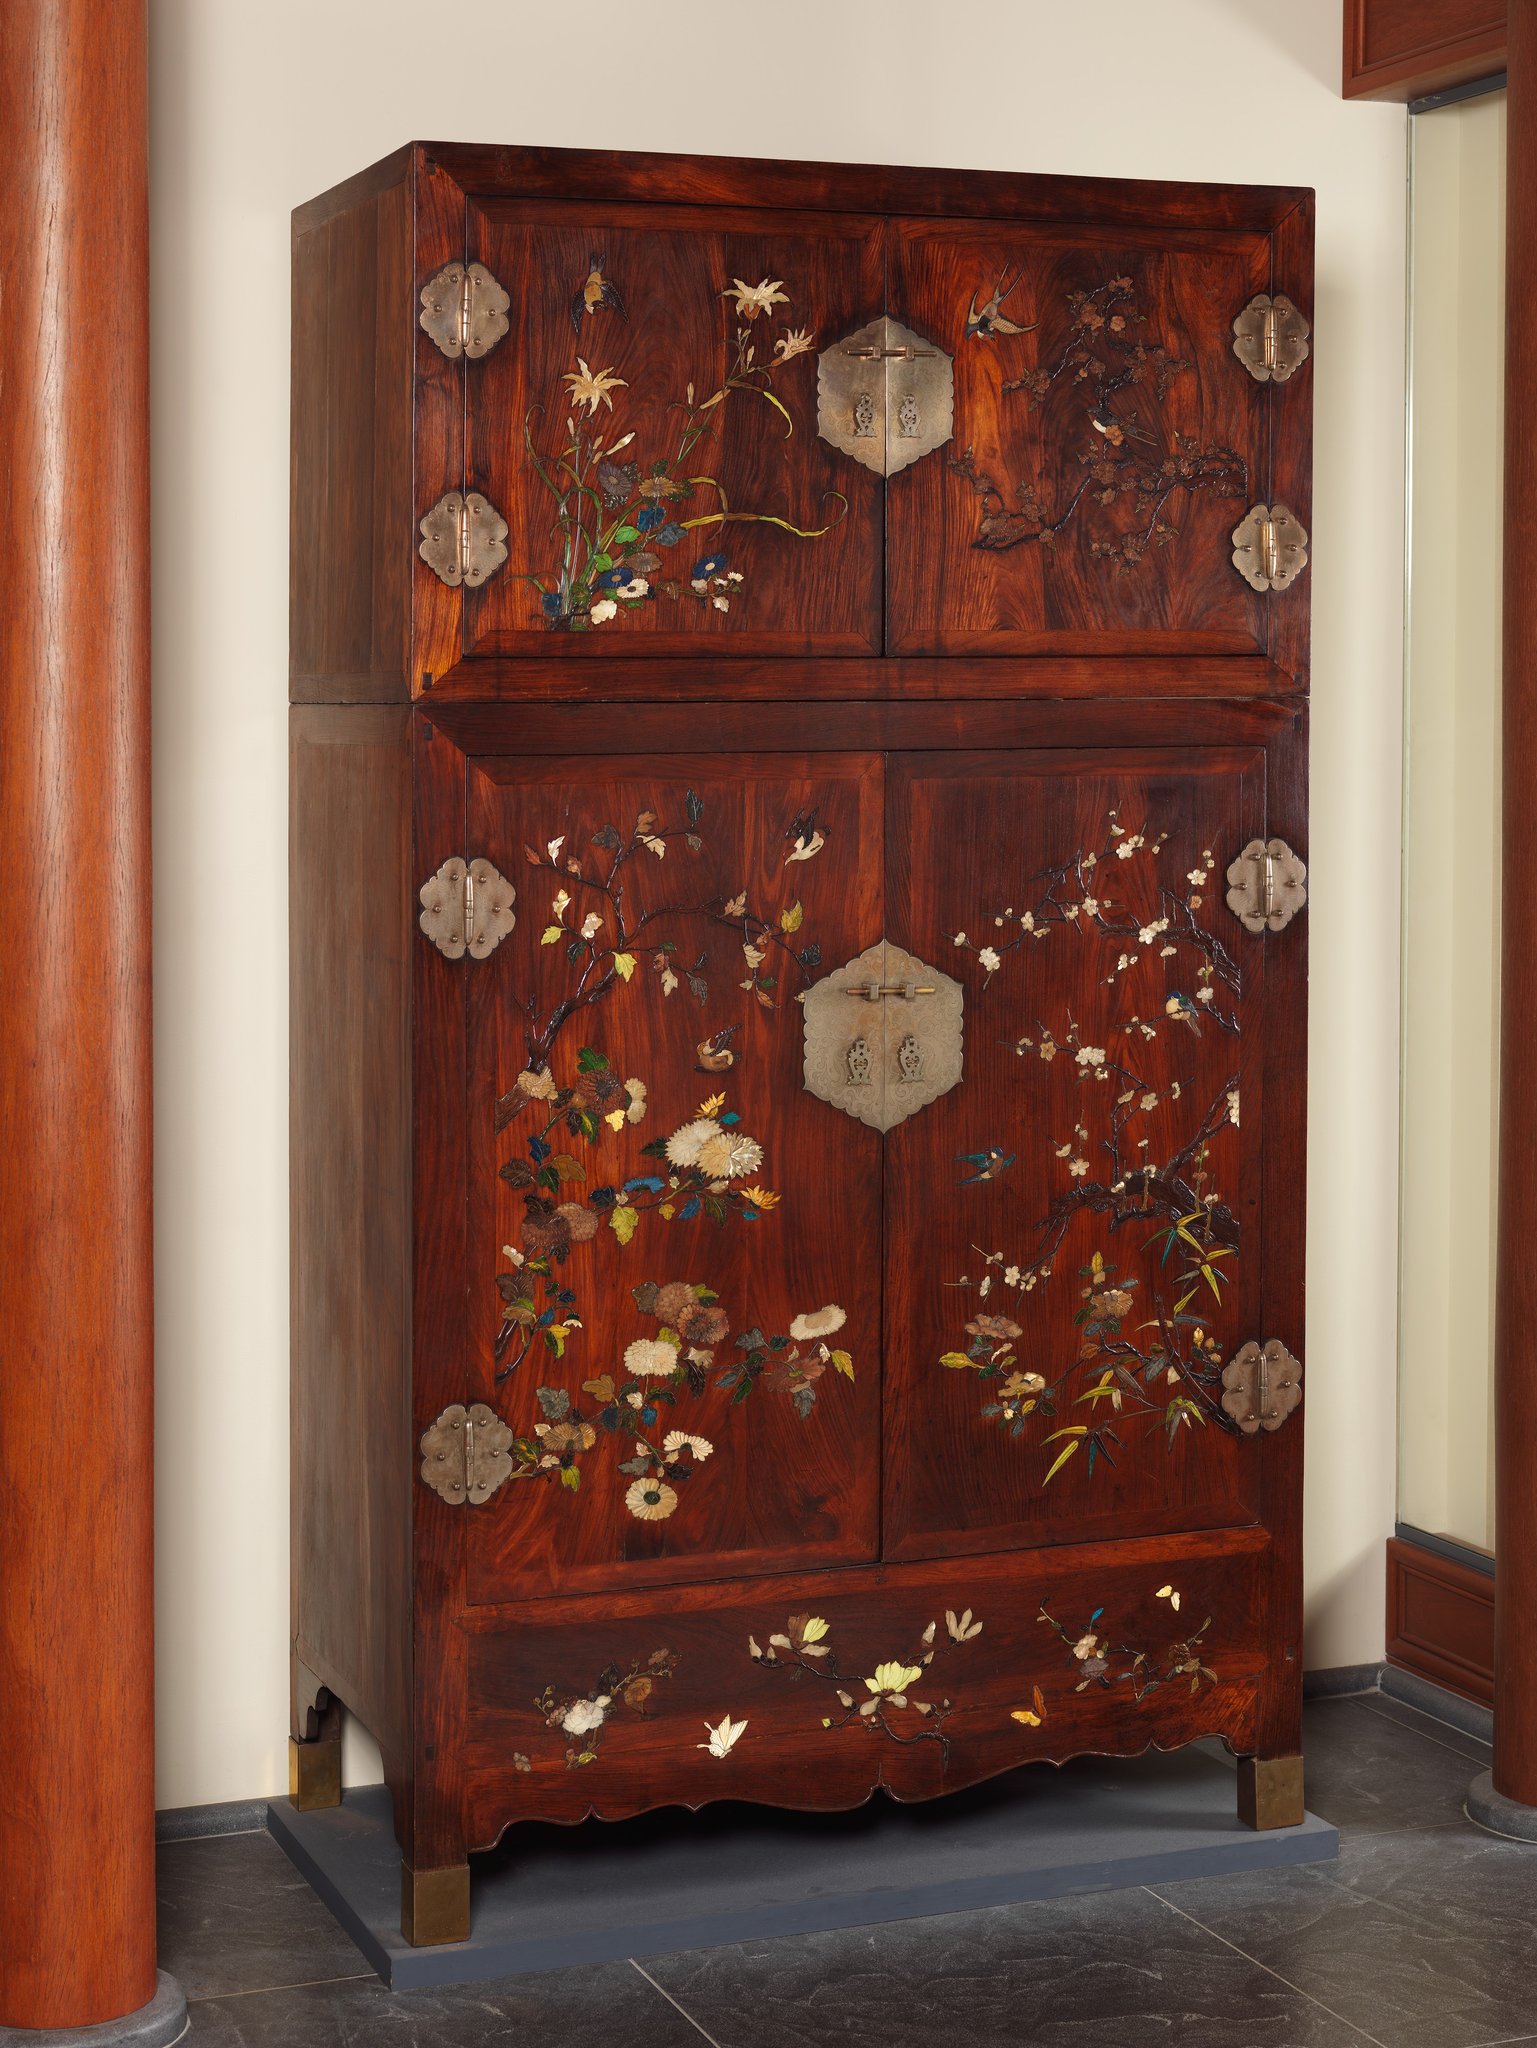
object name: wardrobe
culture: chinese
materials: amber, glass, ivory, mother of pearl, wood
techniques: inlay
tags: birds,flowers